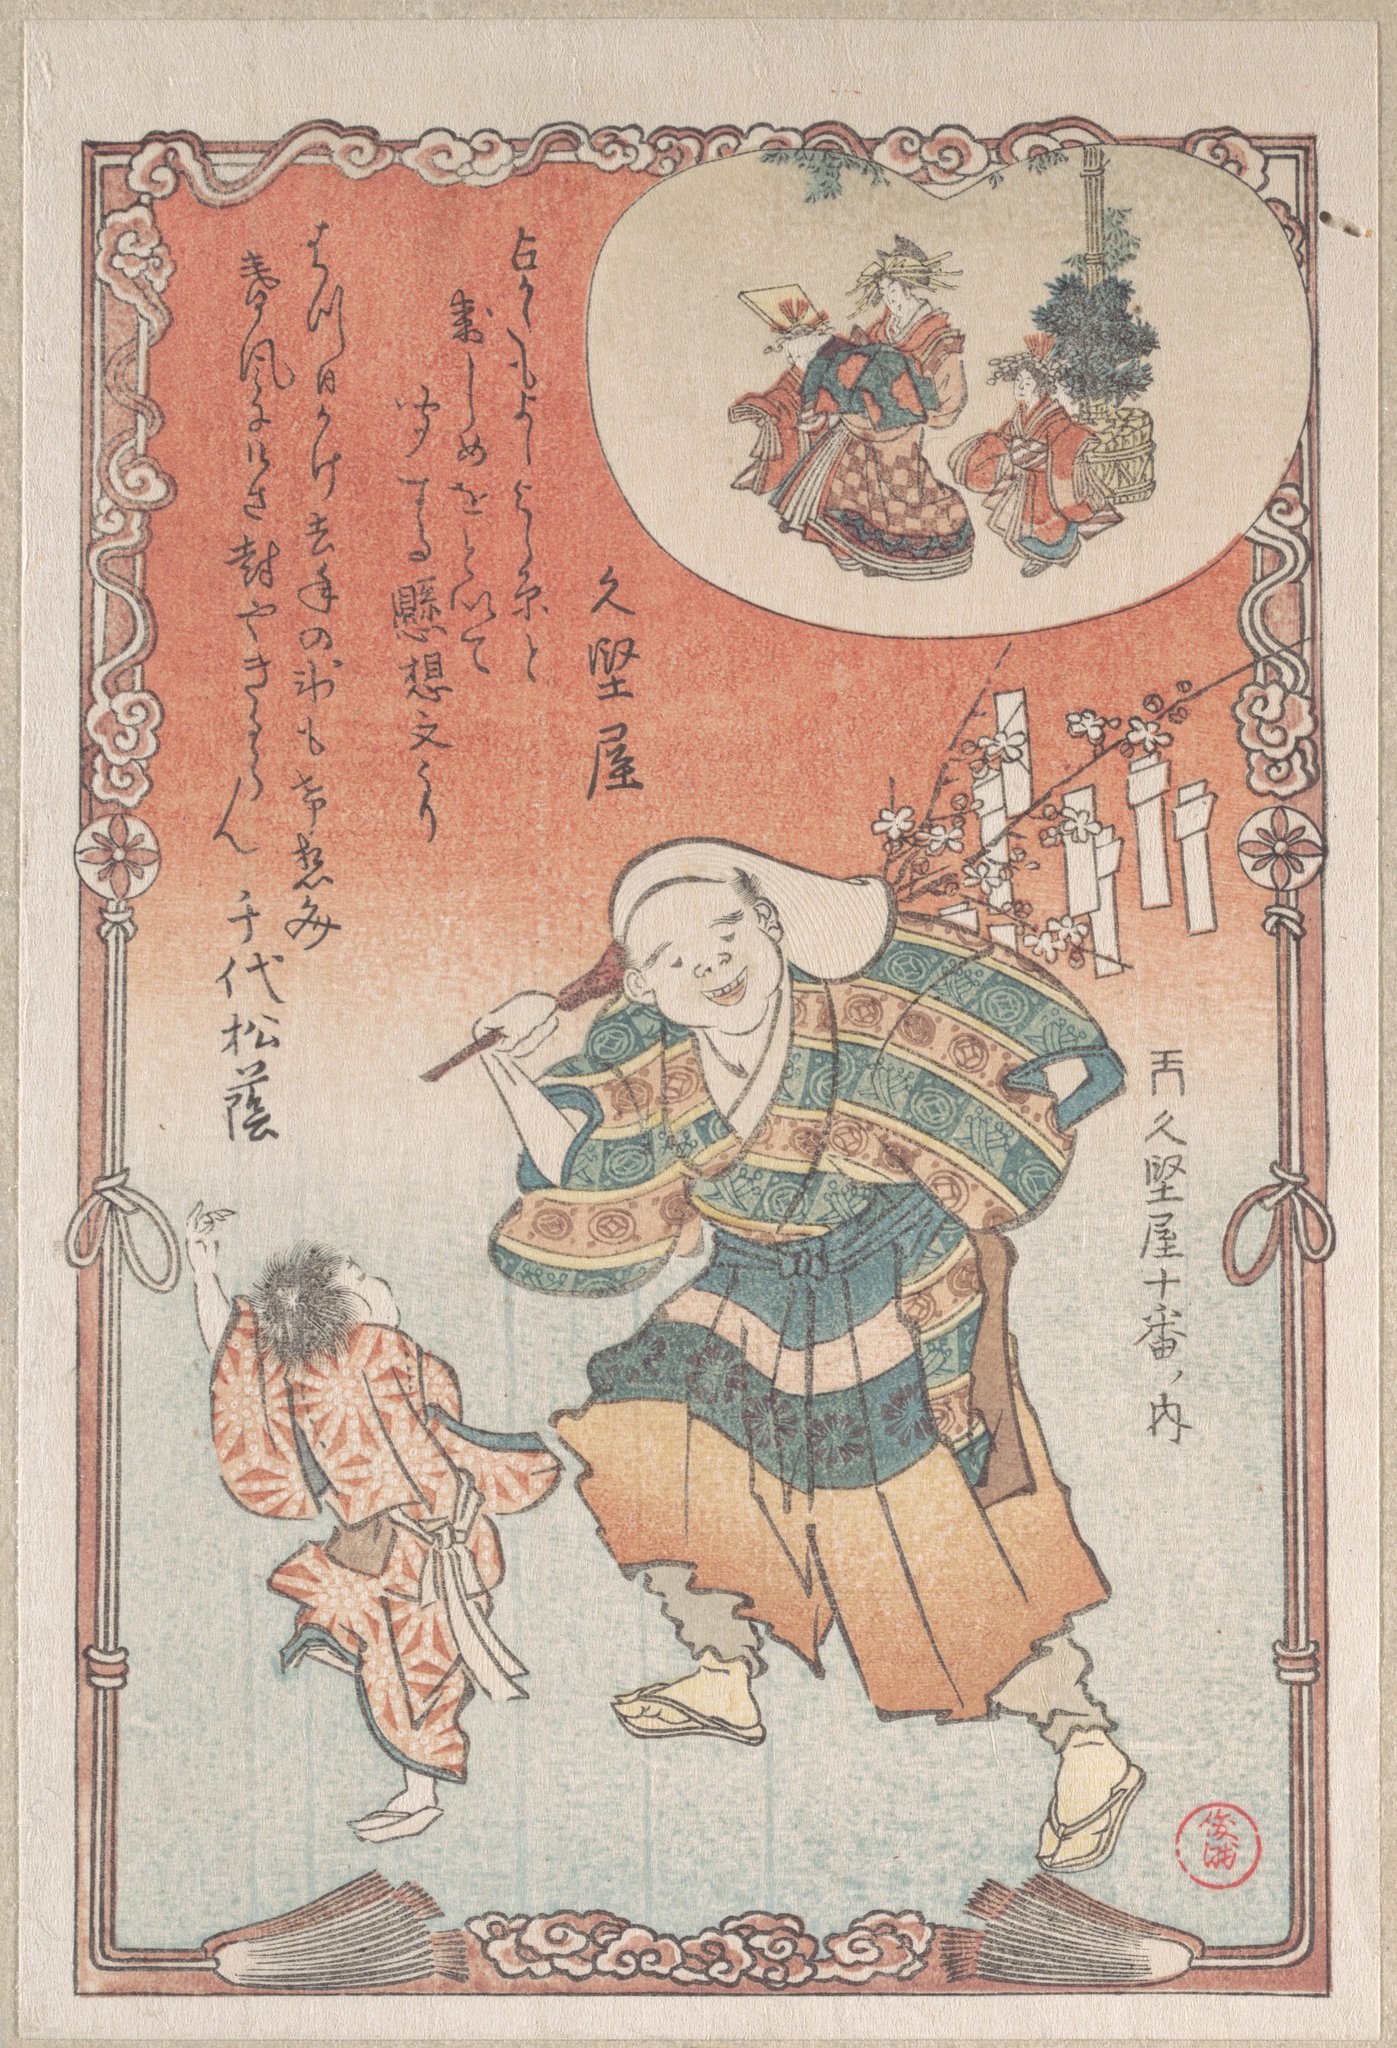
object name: album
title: Hawker of Love Letters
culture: japanese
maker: kubo shunman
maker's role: artist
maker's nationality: japanese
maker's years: 1757-1820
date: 1801-1900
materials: ink, paper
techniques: surimono, woodblock print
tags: men,women